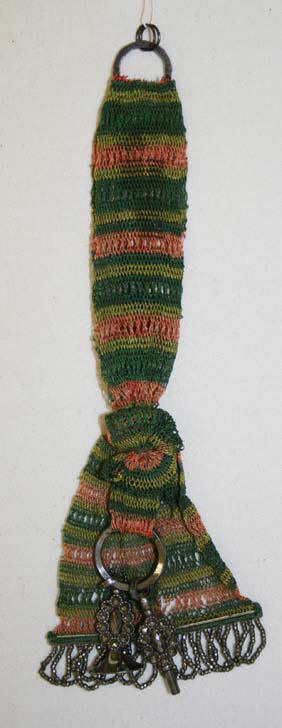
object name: fob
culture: british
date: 1801-1833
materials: metal